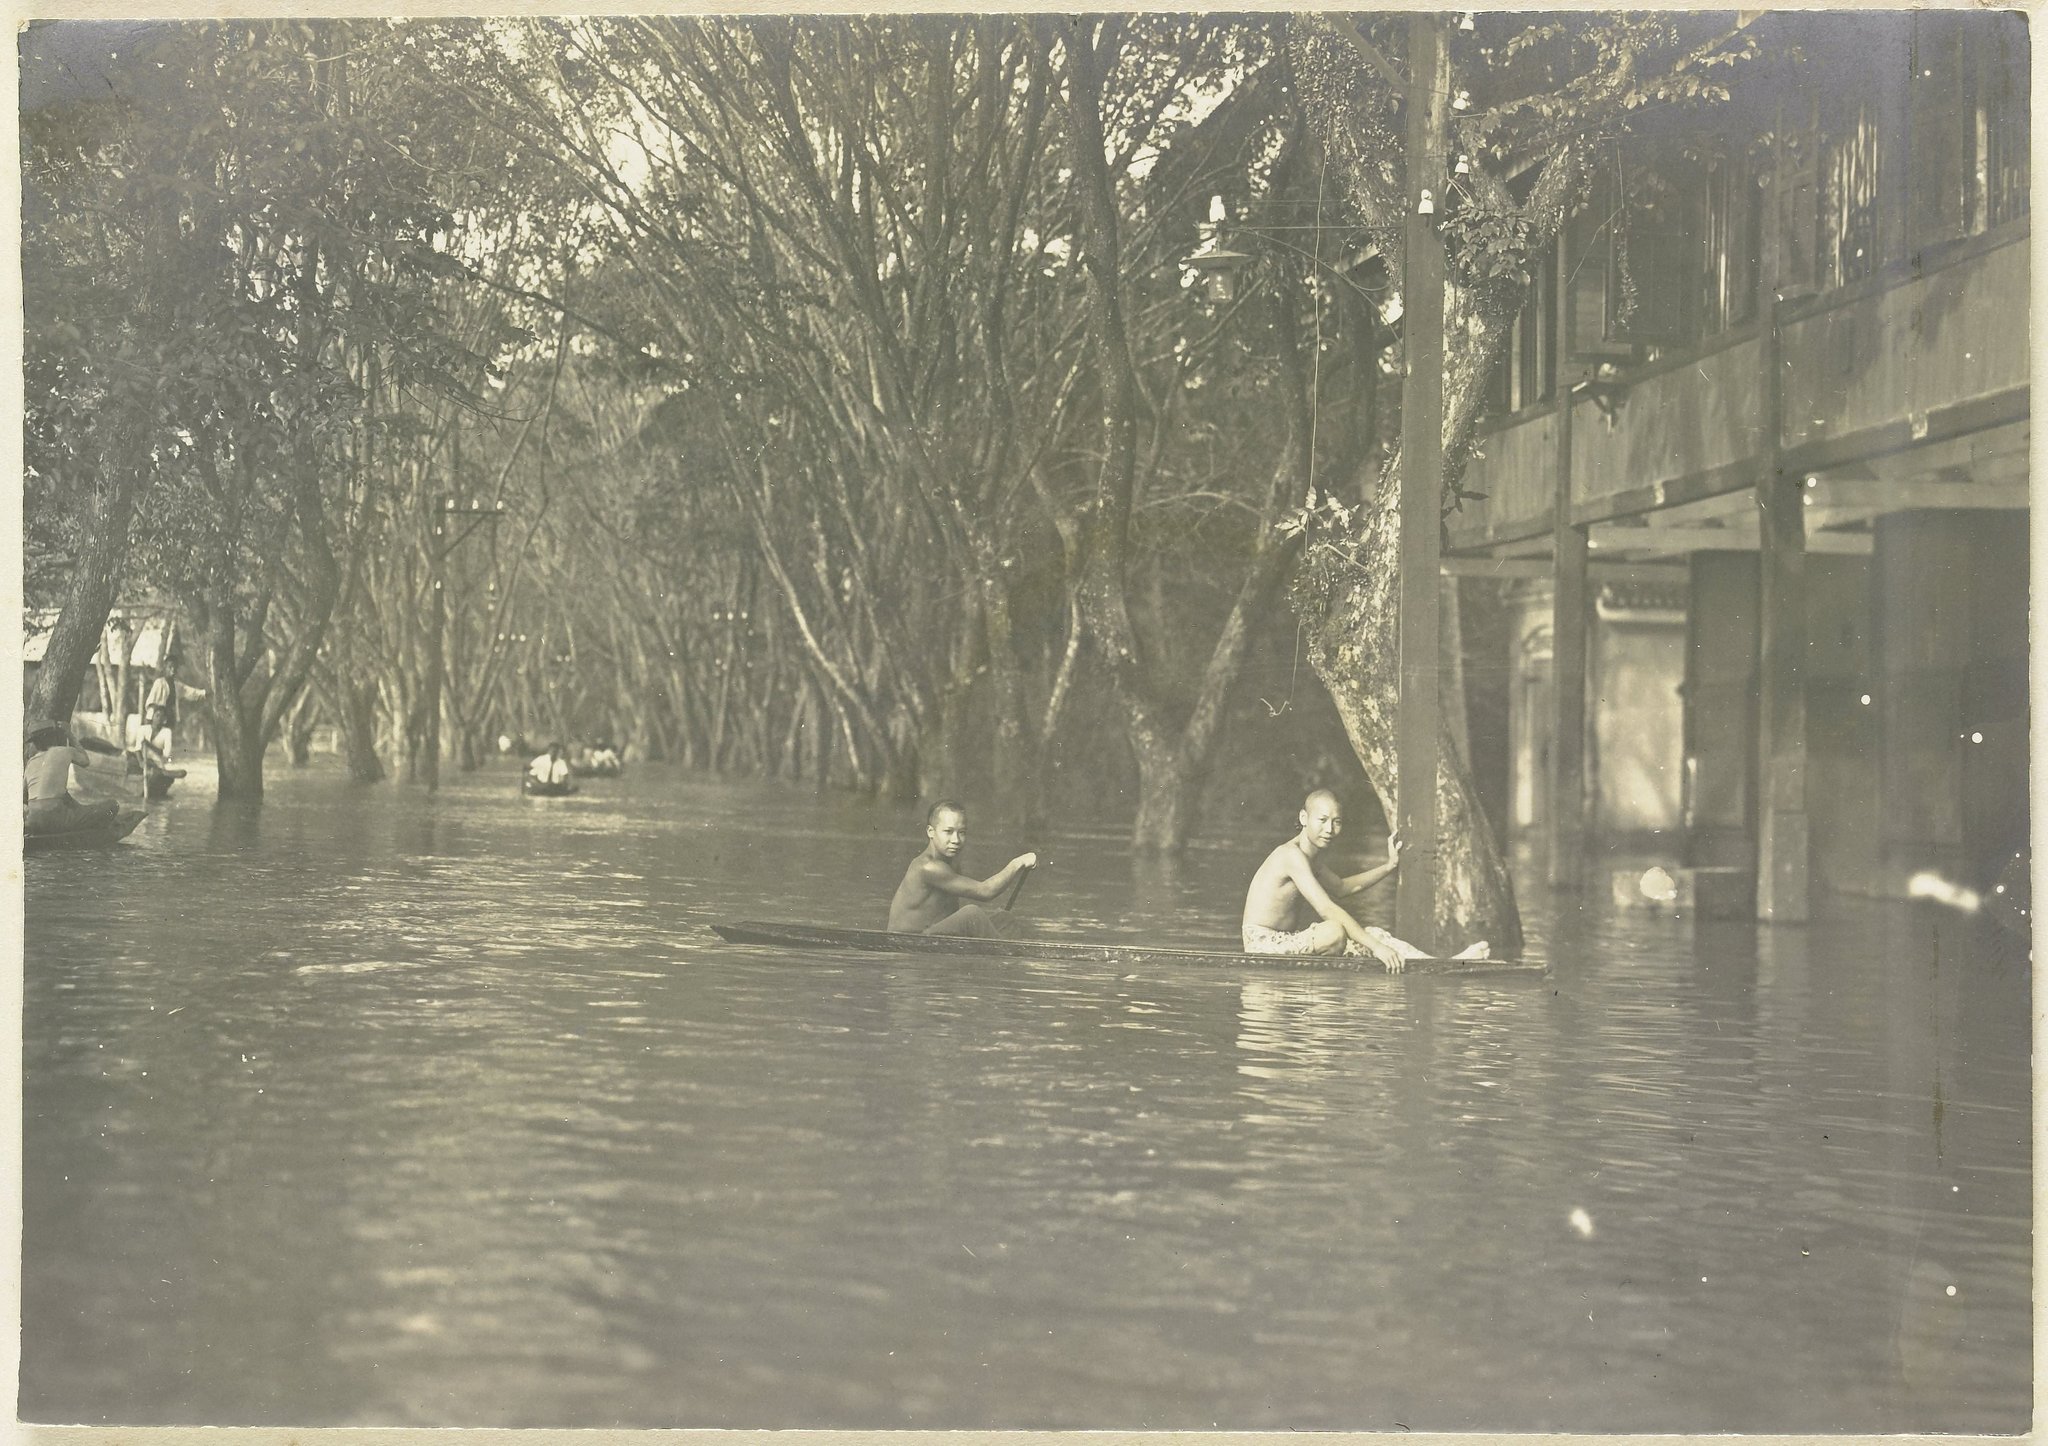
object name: photograph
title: Bootjes voeren door de overstroomde straten van Banjir, Langkat Sumatra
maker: Anonymous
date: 1900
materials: cardboard, paper, photographic support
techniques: gelatin silver print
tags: sumatra